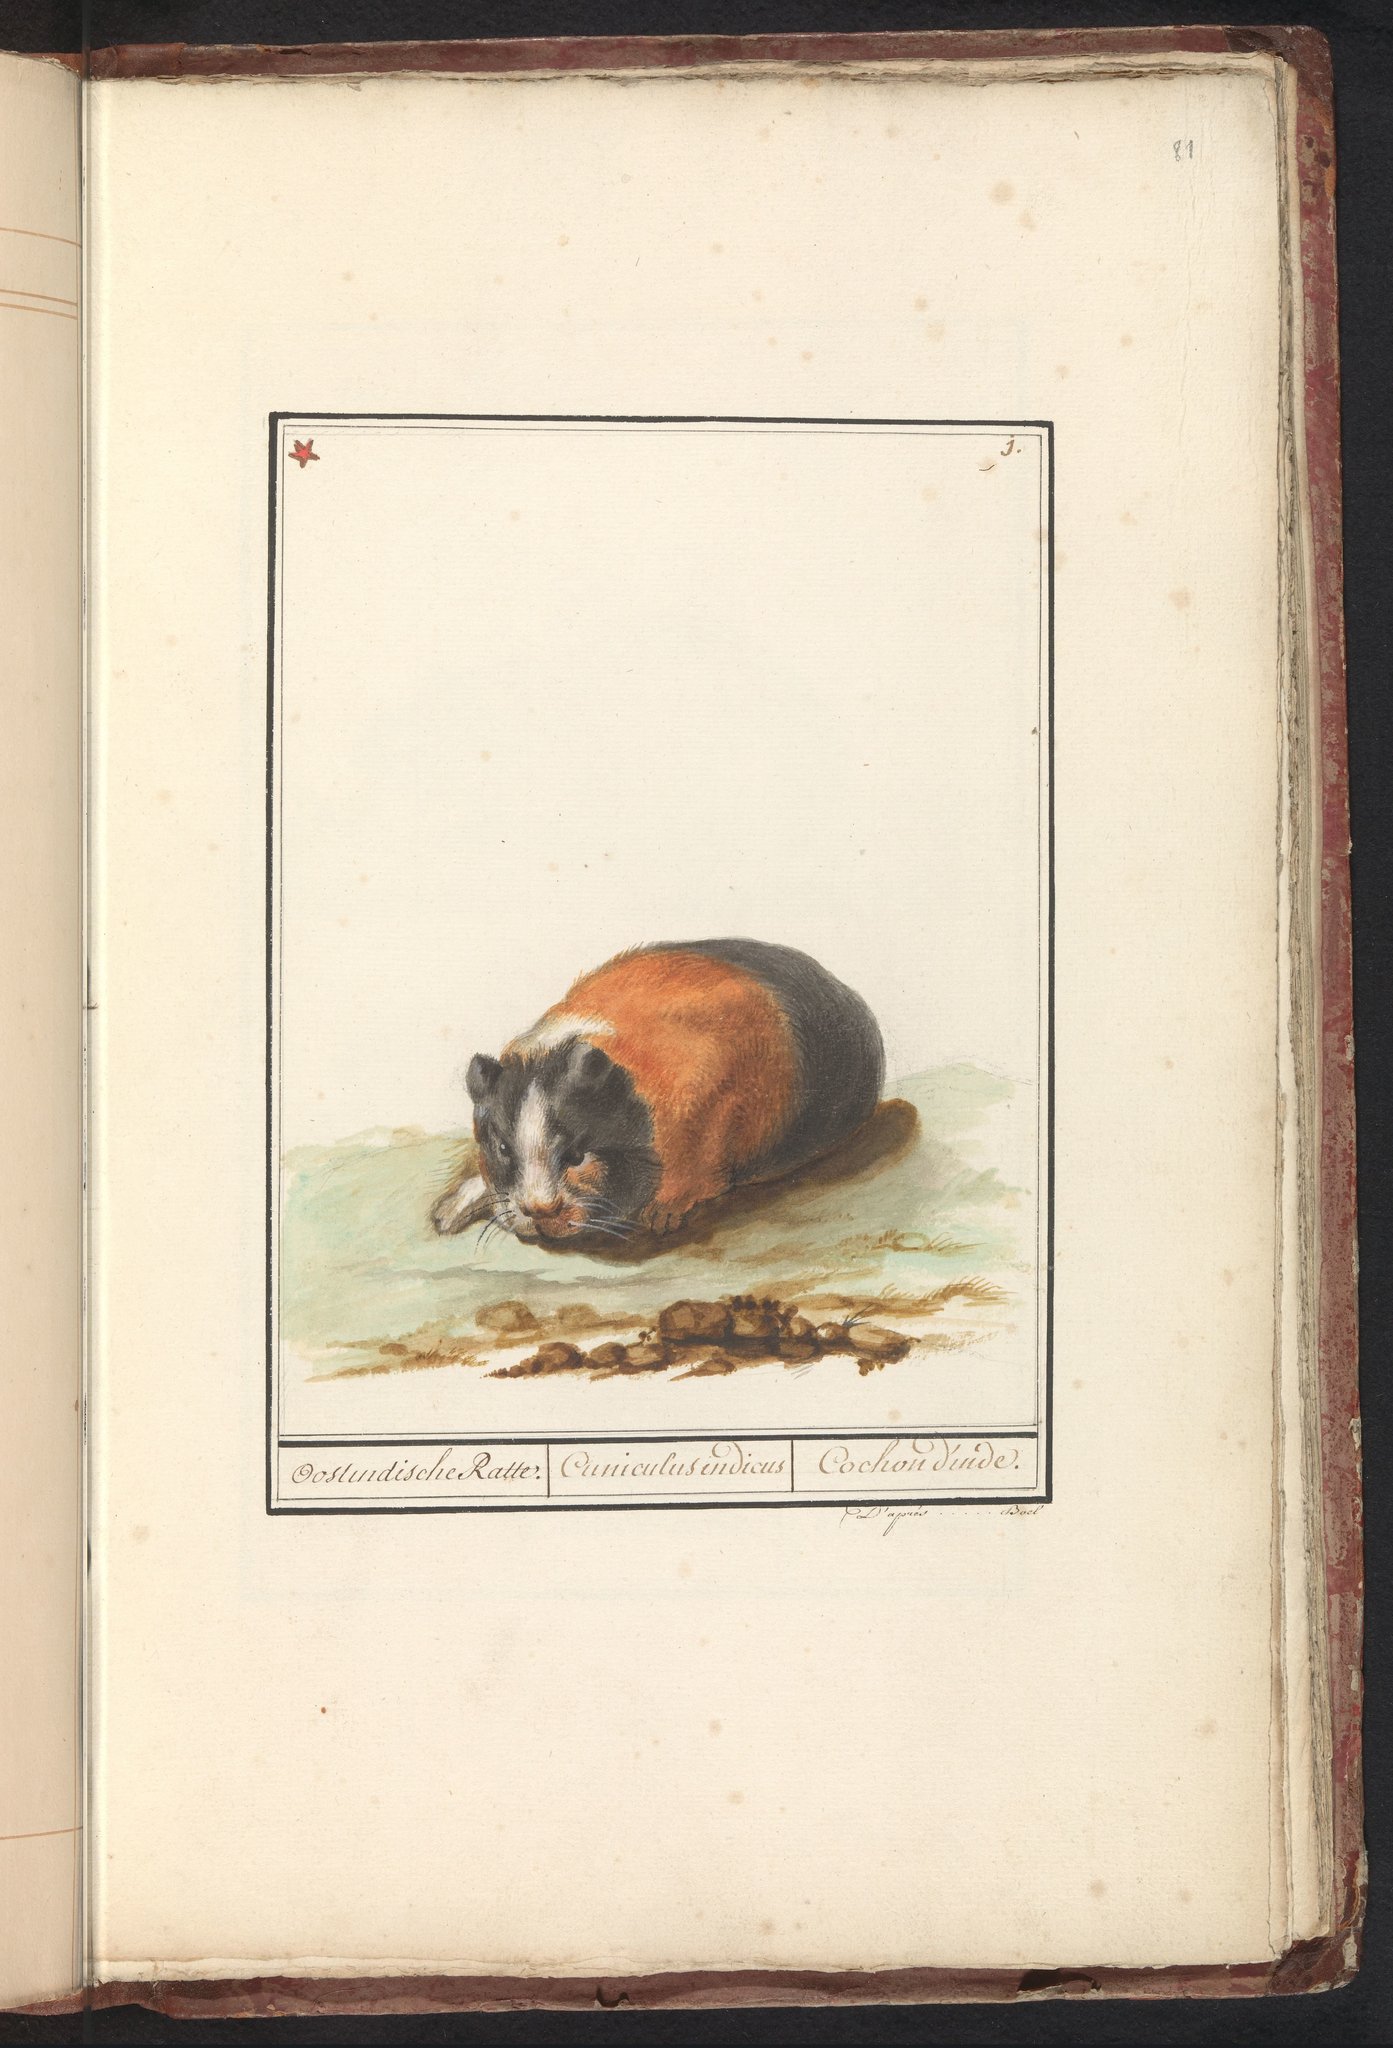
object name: drawing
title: Cavia (Cavia)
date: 1790-1814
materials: chalk, paint, paper, watercolor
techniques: brush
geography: southern netherlands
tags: rodents: guinea pig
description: Cavia of Guinees biggetje. Rechtsboven genummerd: 1. Linksboven gemerkt met een rood sterretje. Onderdeel van het eerste album met tekeningen van viervoeters. Eerste van twaalf albums met tekeningen van dieren, vogels en planten bekend rond 1600, gemaakt in opdracht van keizer Rudolf II. Met toelichting in Nederlands, Latijn en Frans.